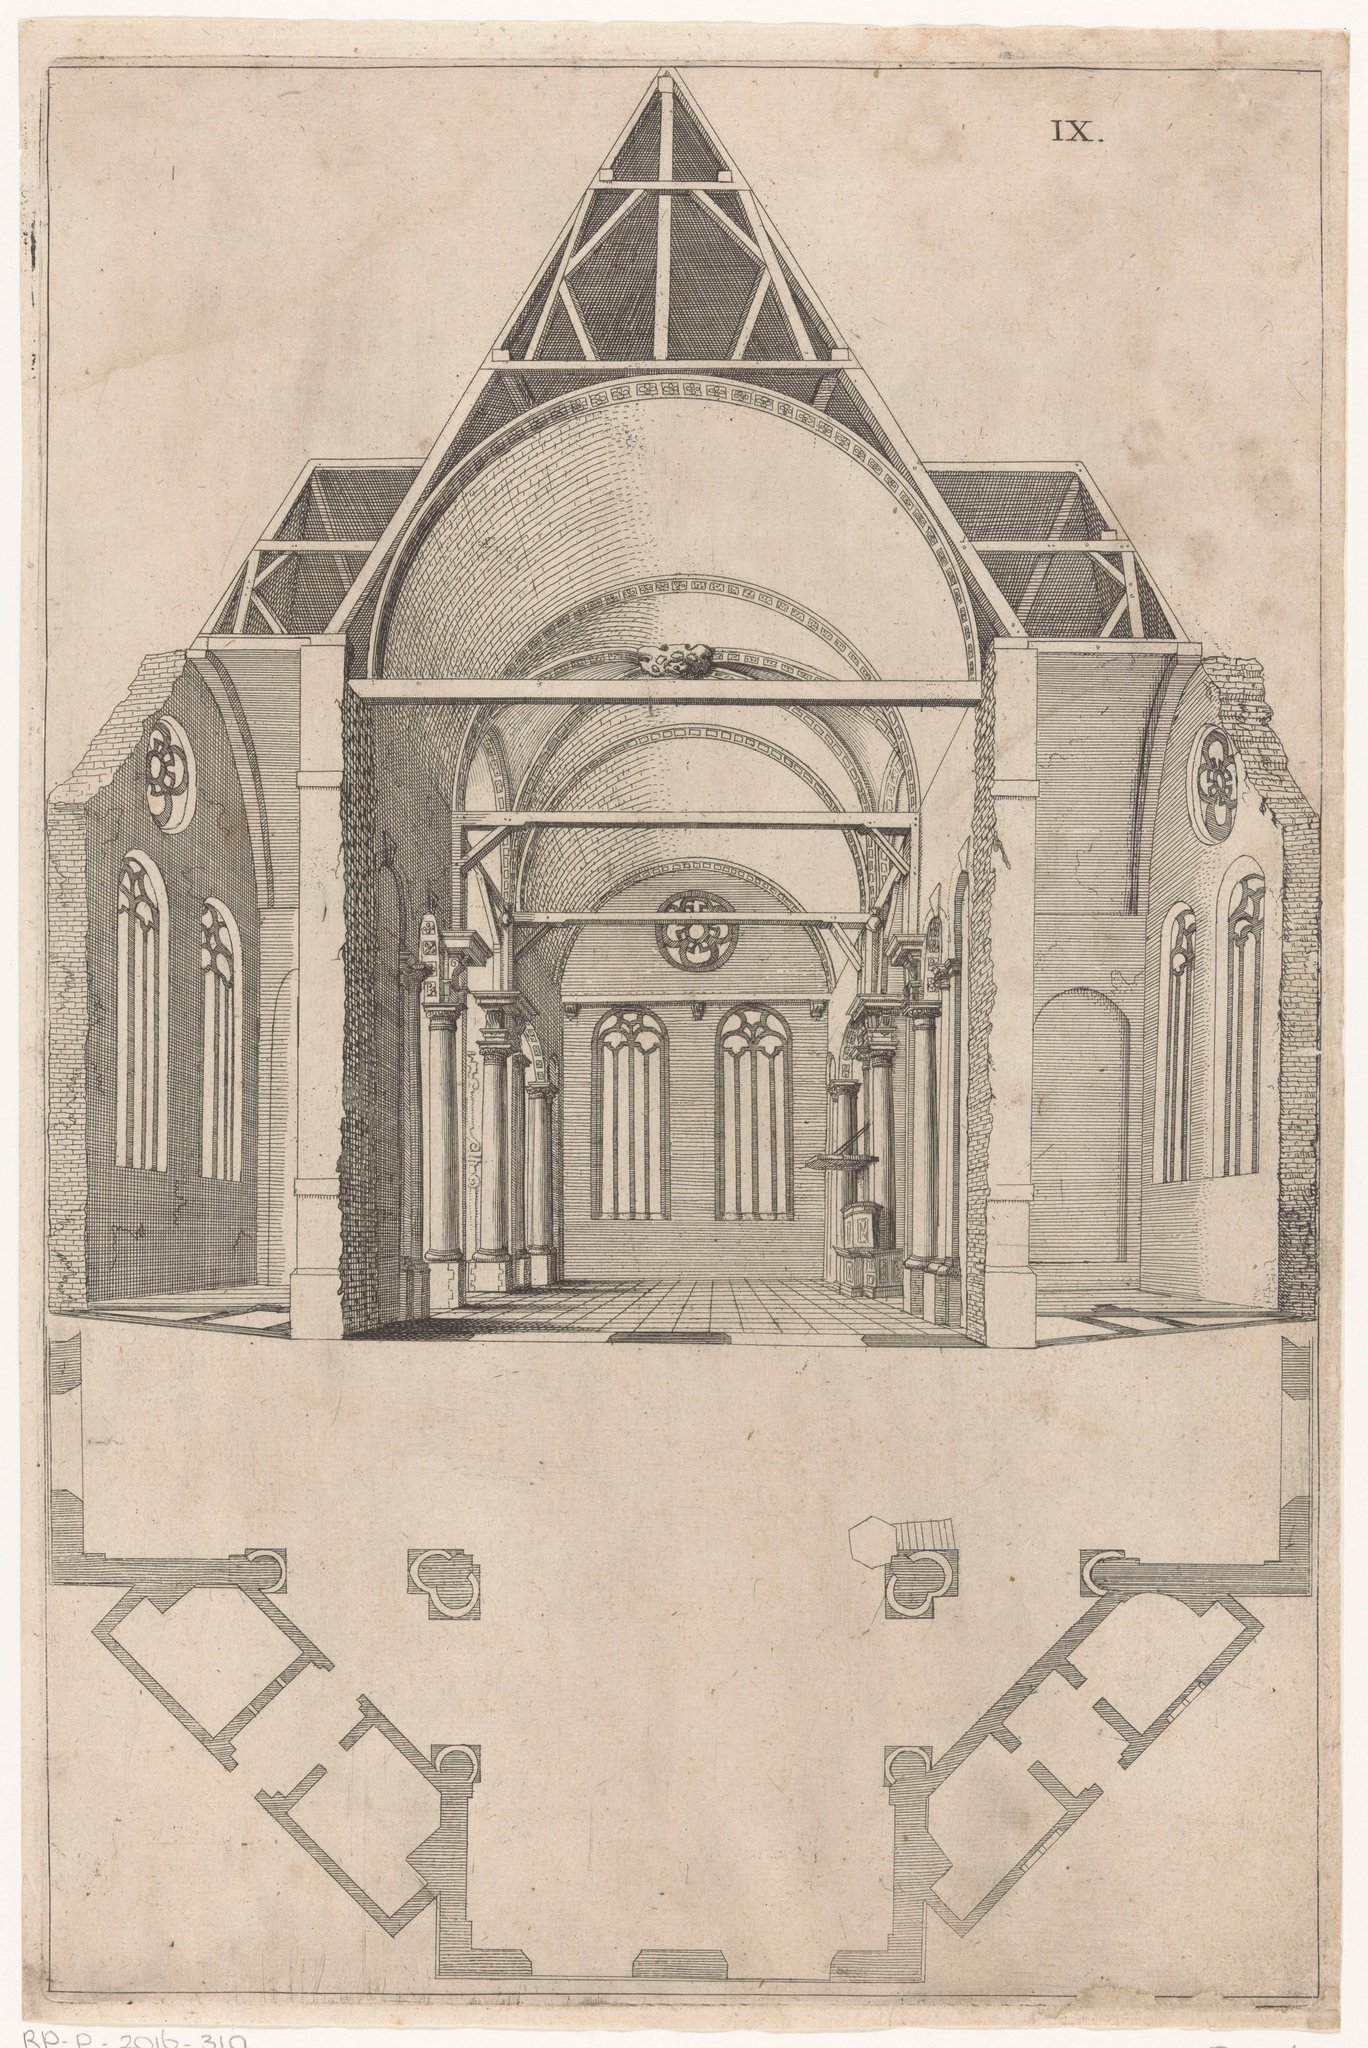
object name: ornament print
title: Dwarsdoorsnede en plattegrond van de Noorderkerk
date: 1631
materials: paper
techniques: engraving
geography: amsterdam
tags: interior of church, plan ~ architecture, section ~ architectural design or model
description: Prent uit: Keyser, Hendrick de. Architectura moderna ofte bouwinge van onsen tyt (...) alle gedaen by (...) Amsterdam: Danckerts, Cornelis, 1631.